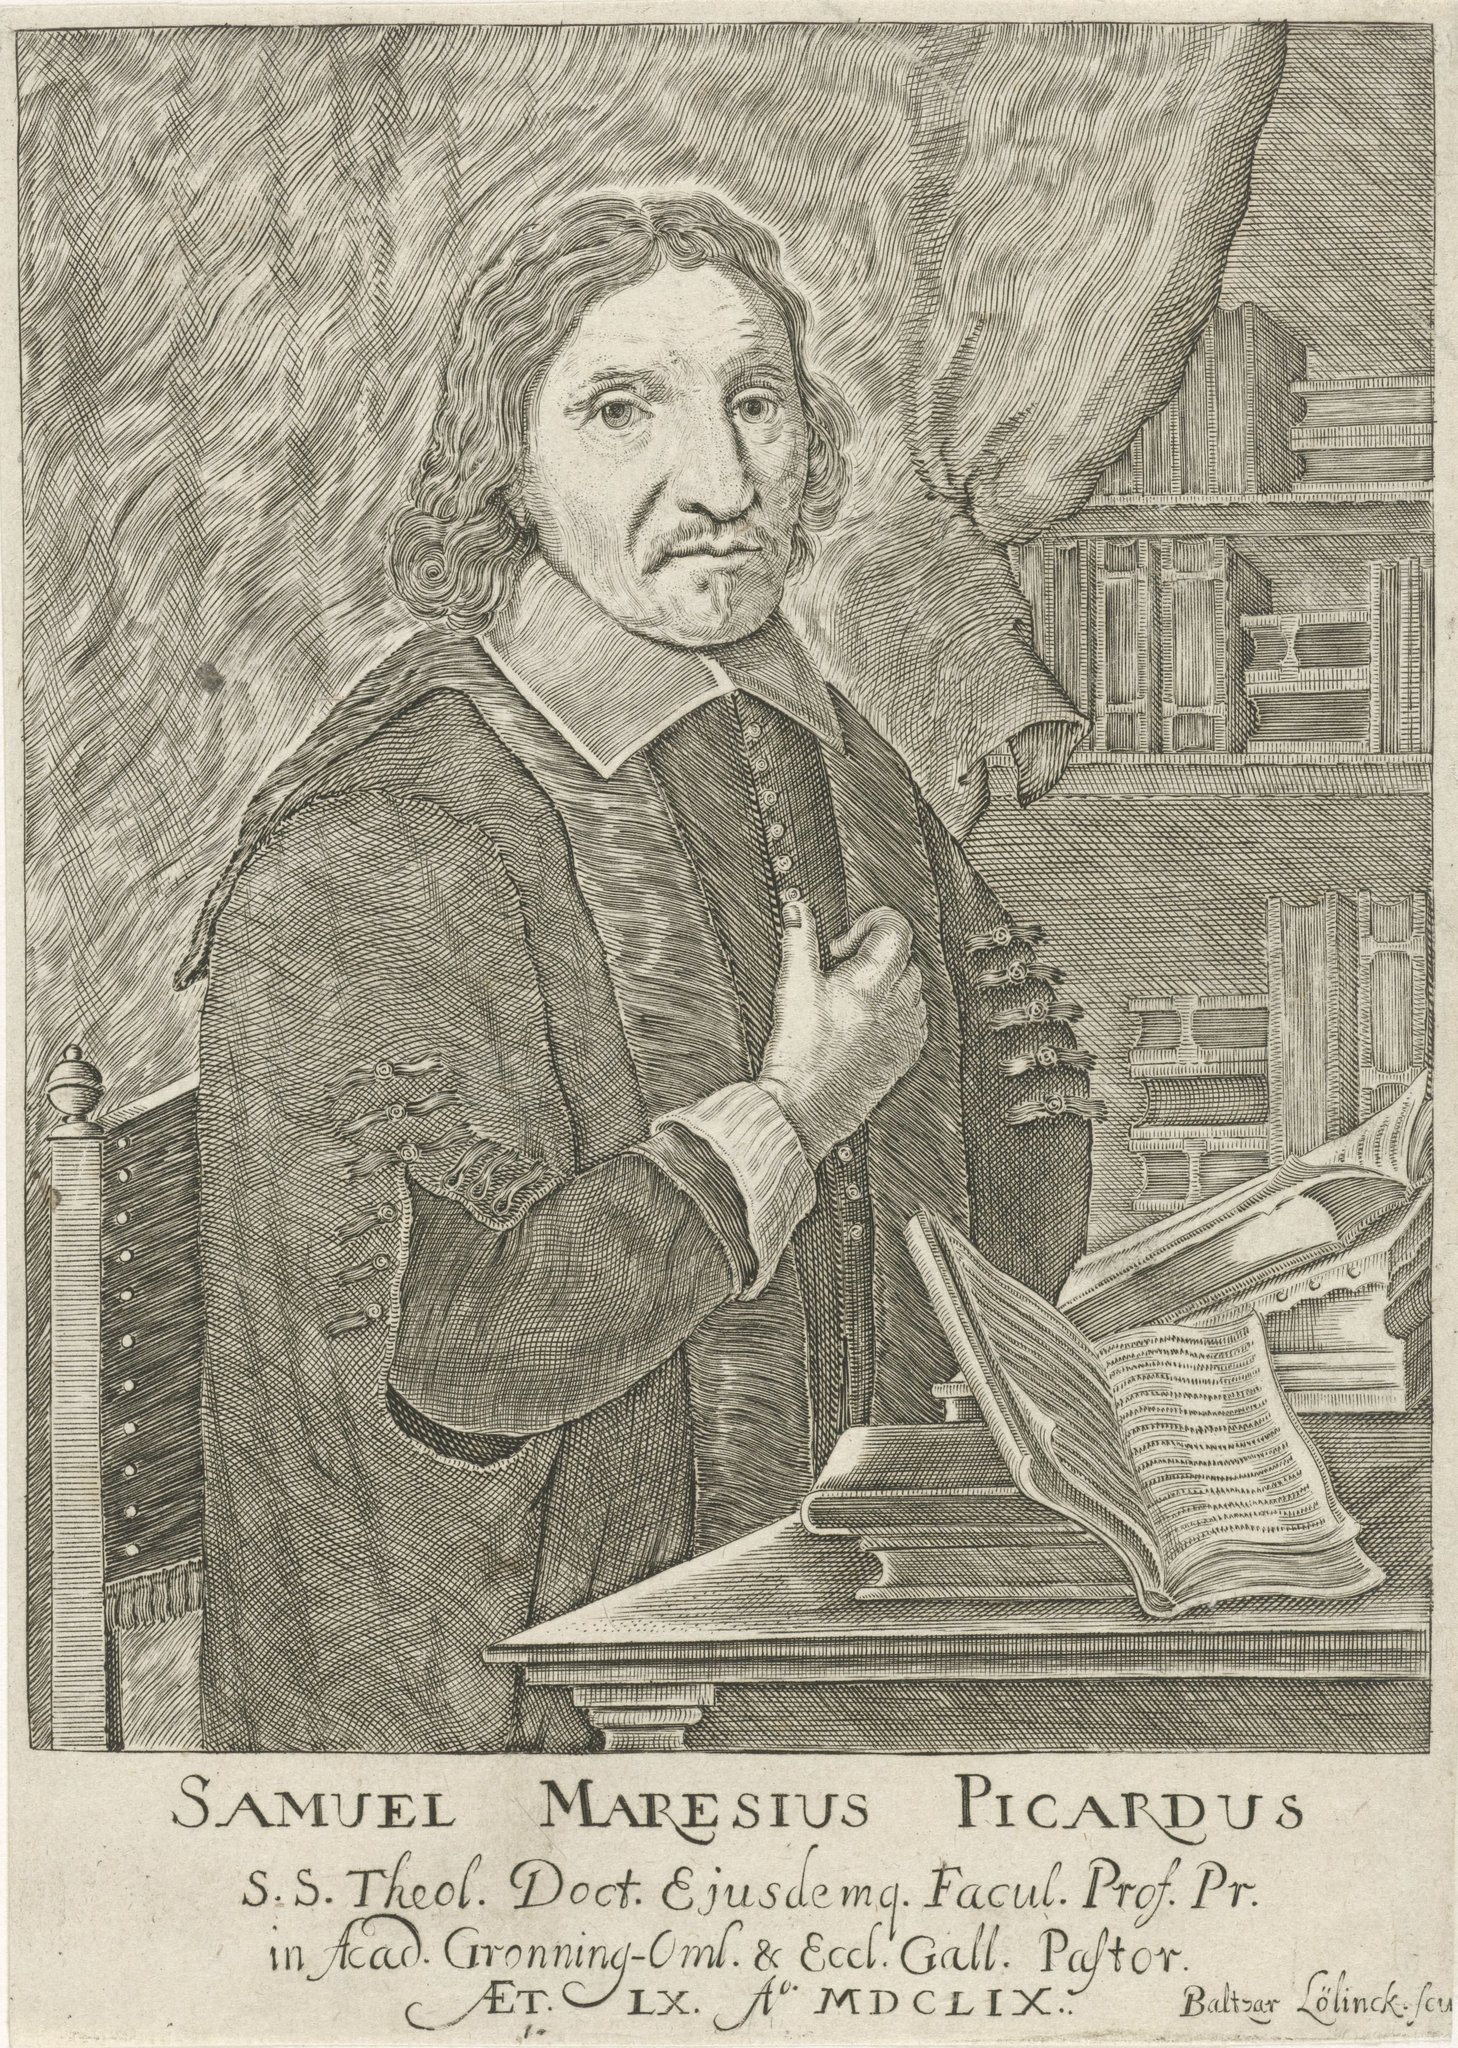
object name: print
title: Portret van Samuel Maresius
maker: baltzar lölinck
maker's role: print maker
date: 1660-1670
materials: paper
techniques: engraving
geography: groningen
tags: professor, samuel maresius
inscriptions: collector's mark: Lugt 2228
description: Portret van Samuel Maresius, predikant en hoogleraar in de theologie te Groningen.